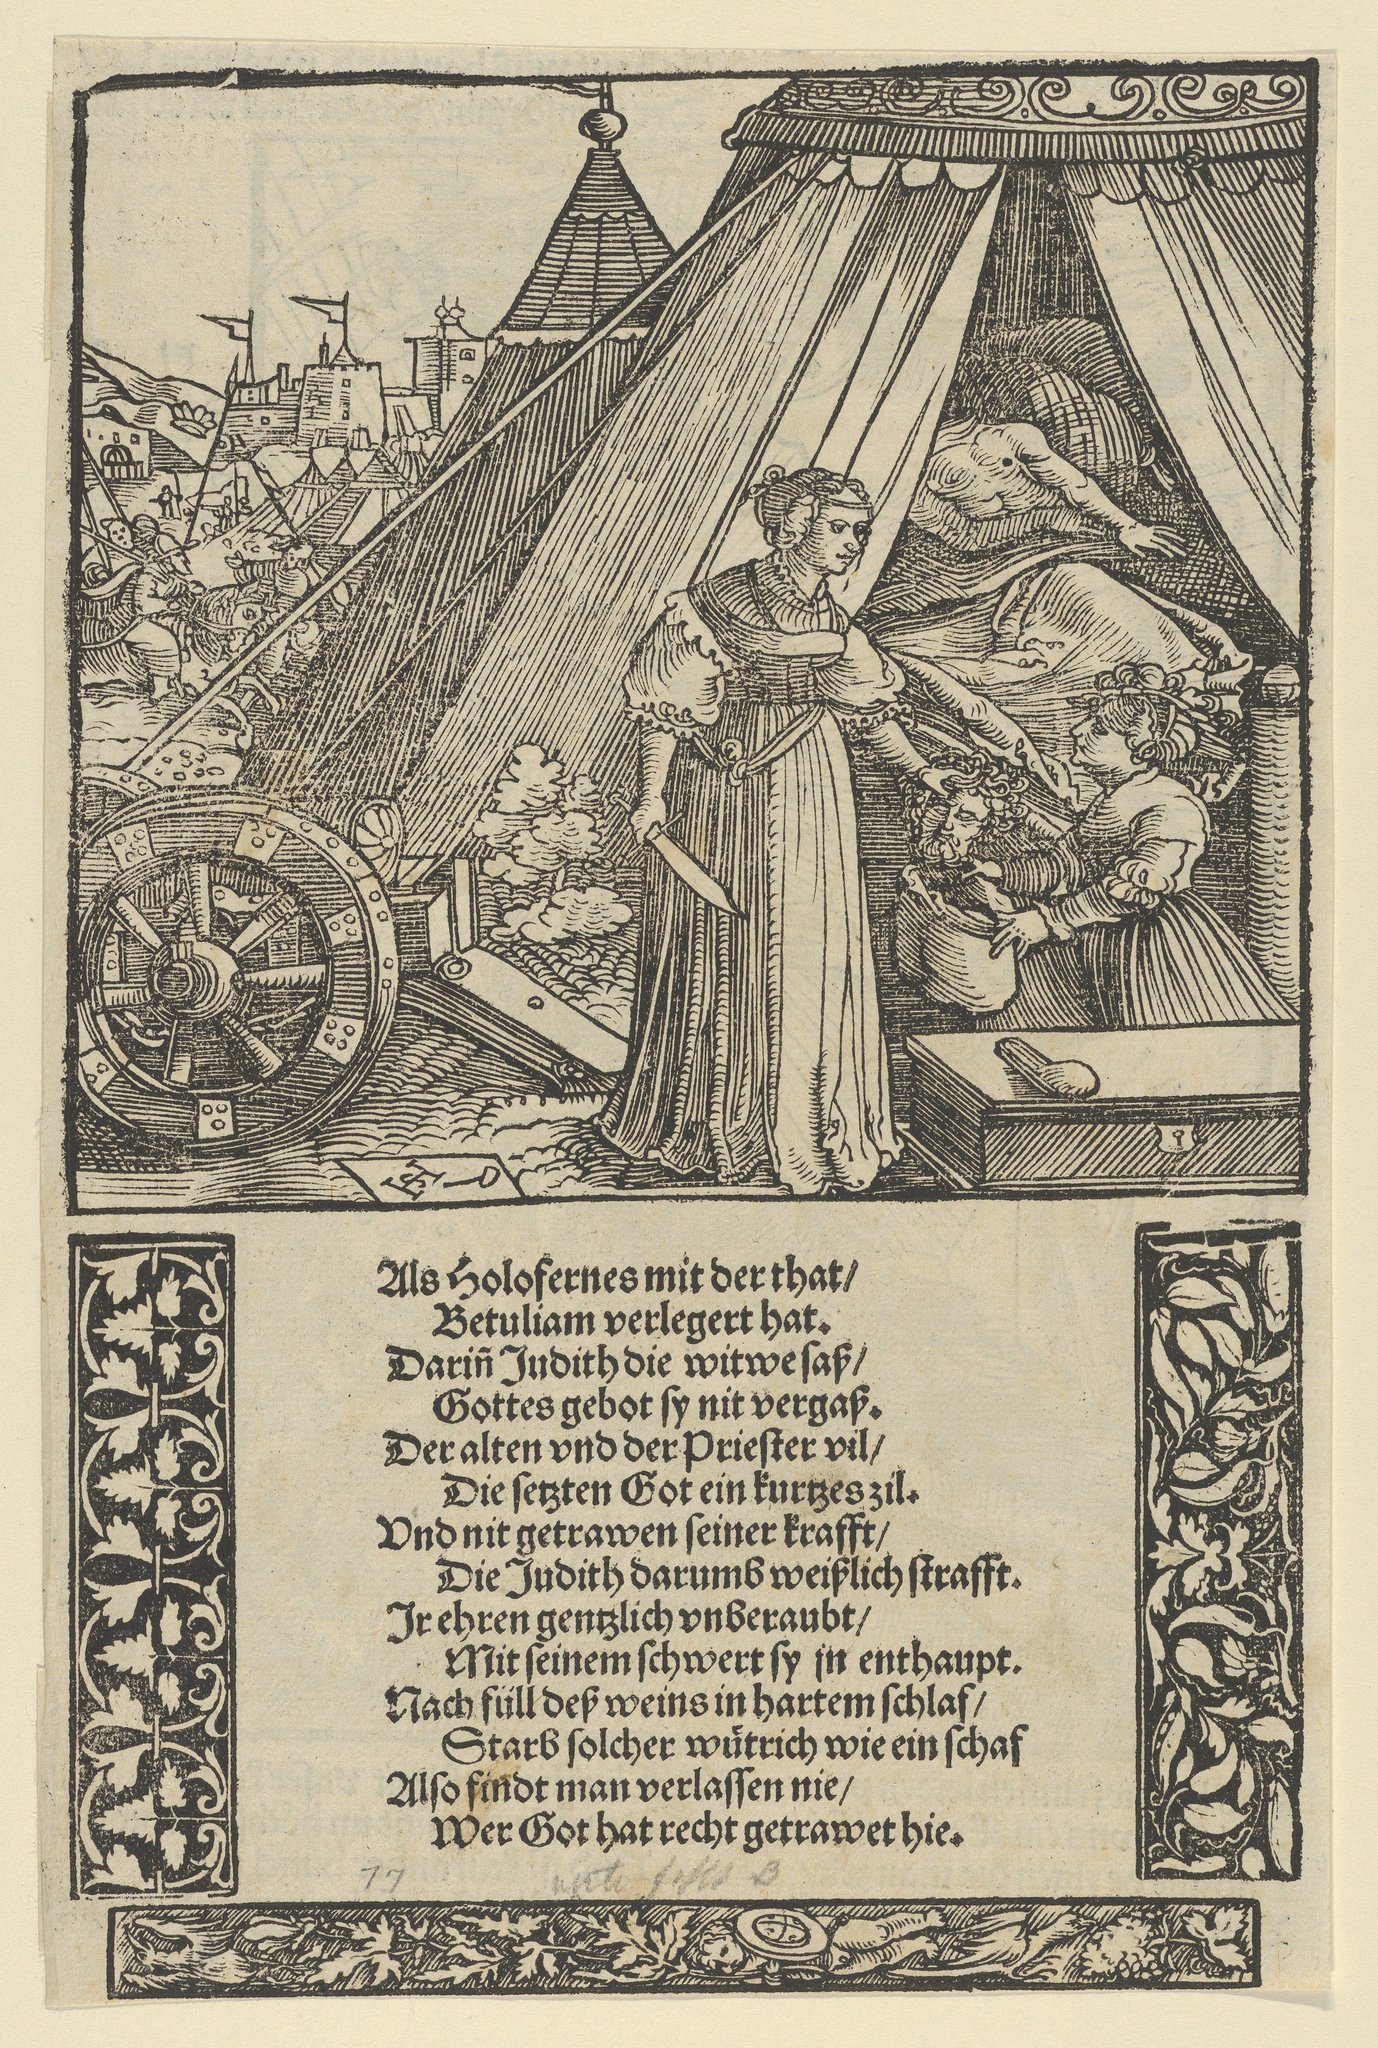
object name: print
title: Judith with the Head of Holophernes, from "Das Büchle Memorial"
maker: hans schäufelein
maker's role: artist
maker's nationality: german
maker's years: 1480-1540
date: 1533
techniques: woodcut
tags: women,holofernes,judith